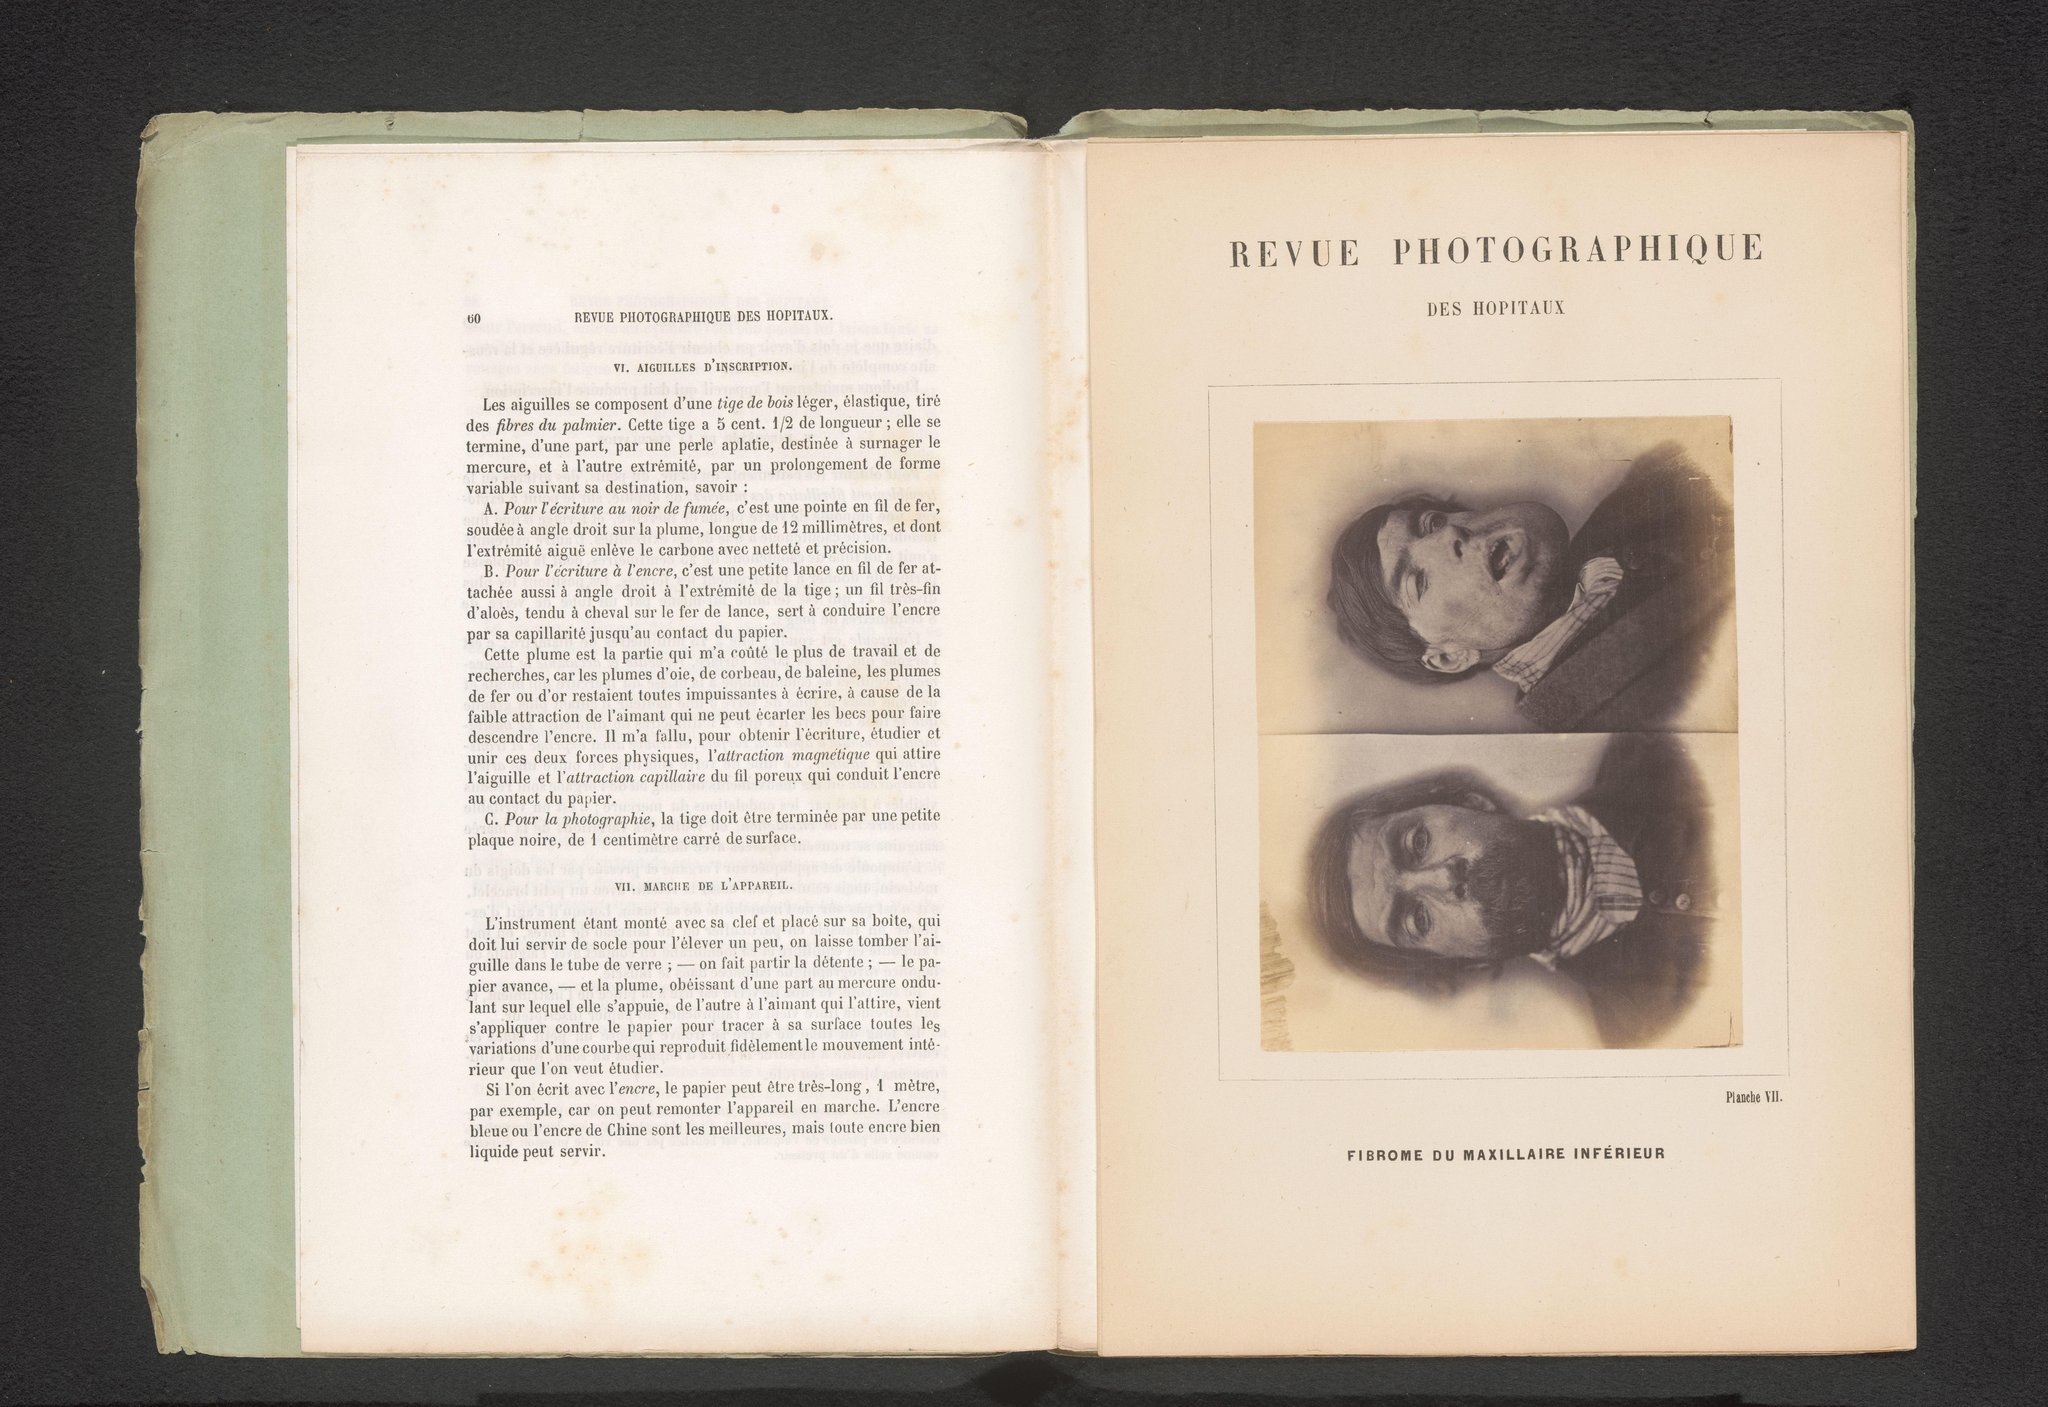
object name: page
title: Twee portretten van een onbekende man met een tumor op de onderkaak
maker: Anonymous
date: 1865-1870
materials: paper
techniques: albumen print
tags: tumours, medical research, branches of medicine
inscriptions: inscription: ‘Revue photographique/ des hopitaux/ Planche VII.’